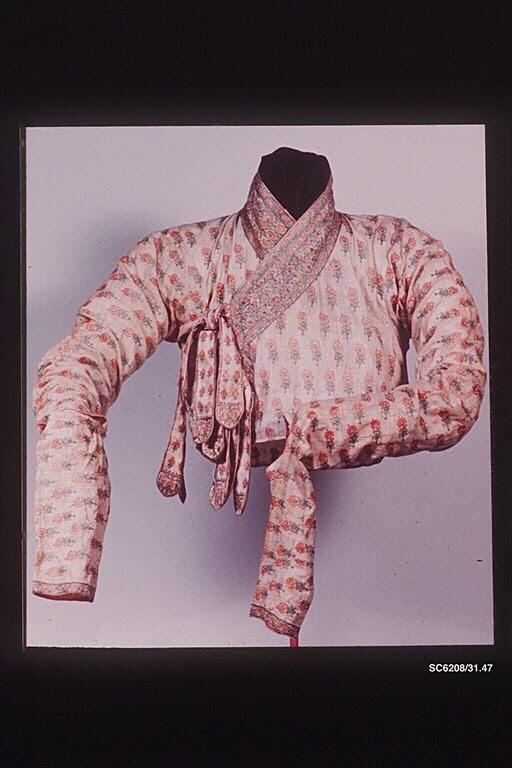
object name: fragment of a robe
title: Fragment of a Robe (Jama)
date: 1628-1658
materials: cotton, silk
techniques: embroidery, weave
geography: india